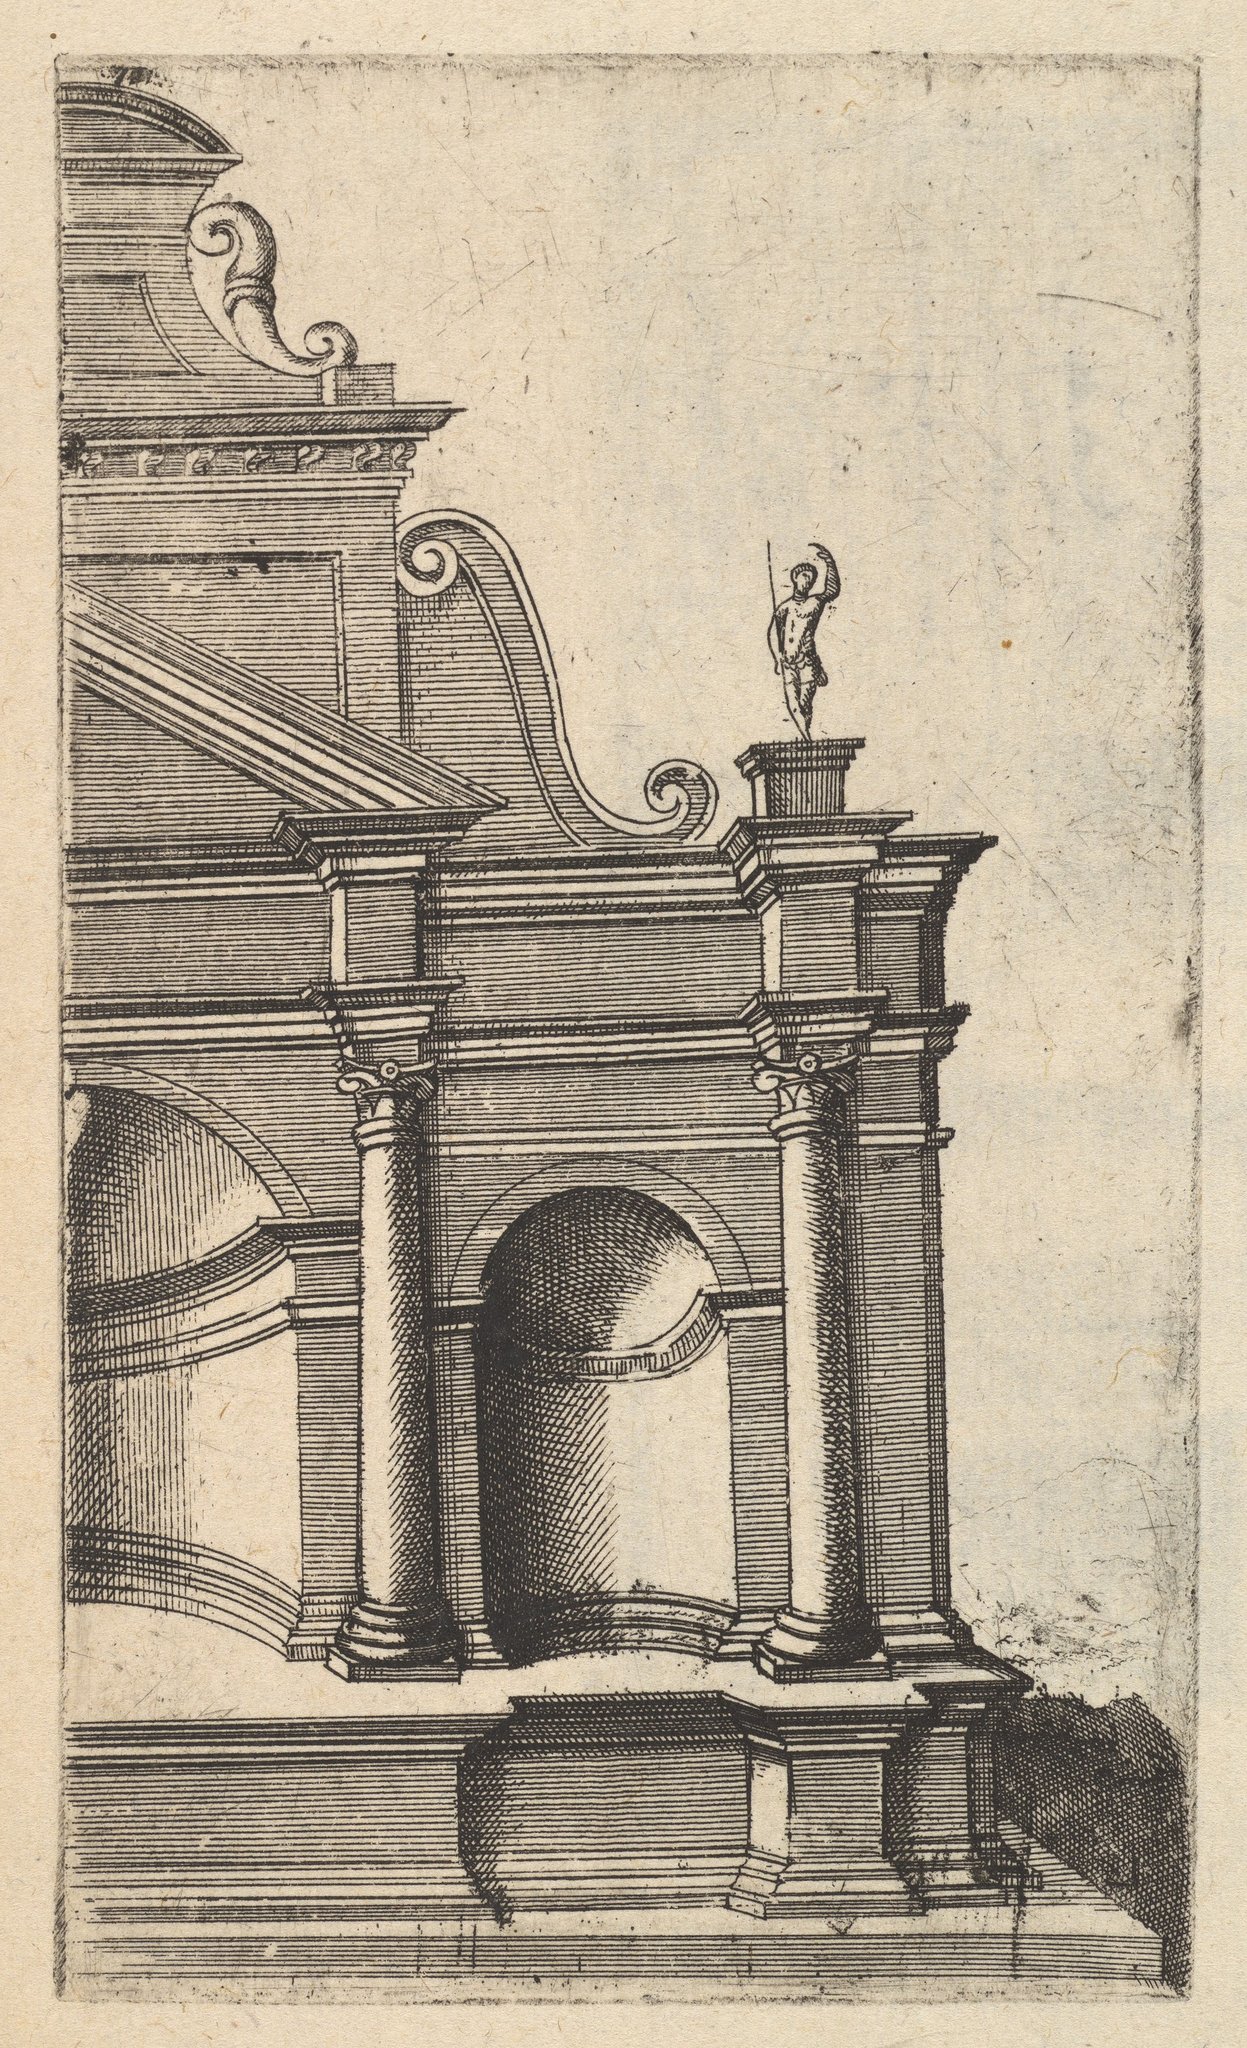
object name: book print ornament architecture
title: Partial View of a Monument [Mercurii Templum] from the series 'Ruinarum variarum fabricarum delineationes pictoribus caeterisque id genus artificibus multum utiles'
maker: lambert suavius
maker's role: artist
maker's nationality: netherlandish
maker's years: 1510-1576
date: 1554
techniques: etching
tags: monuments